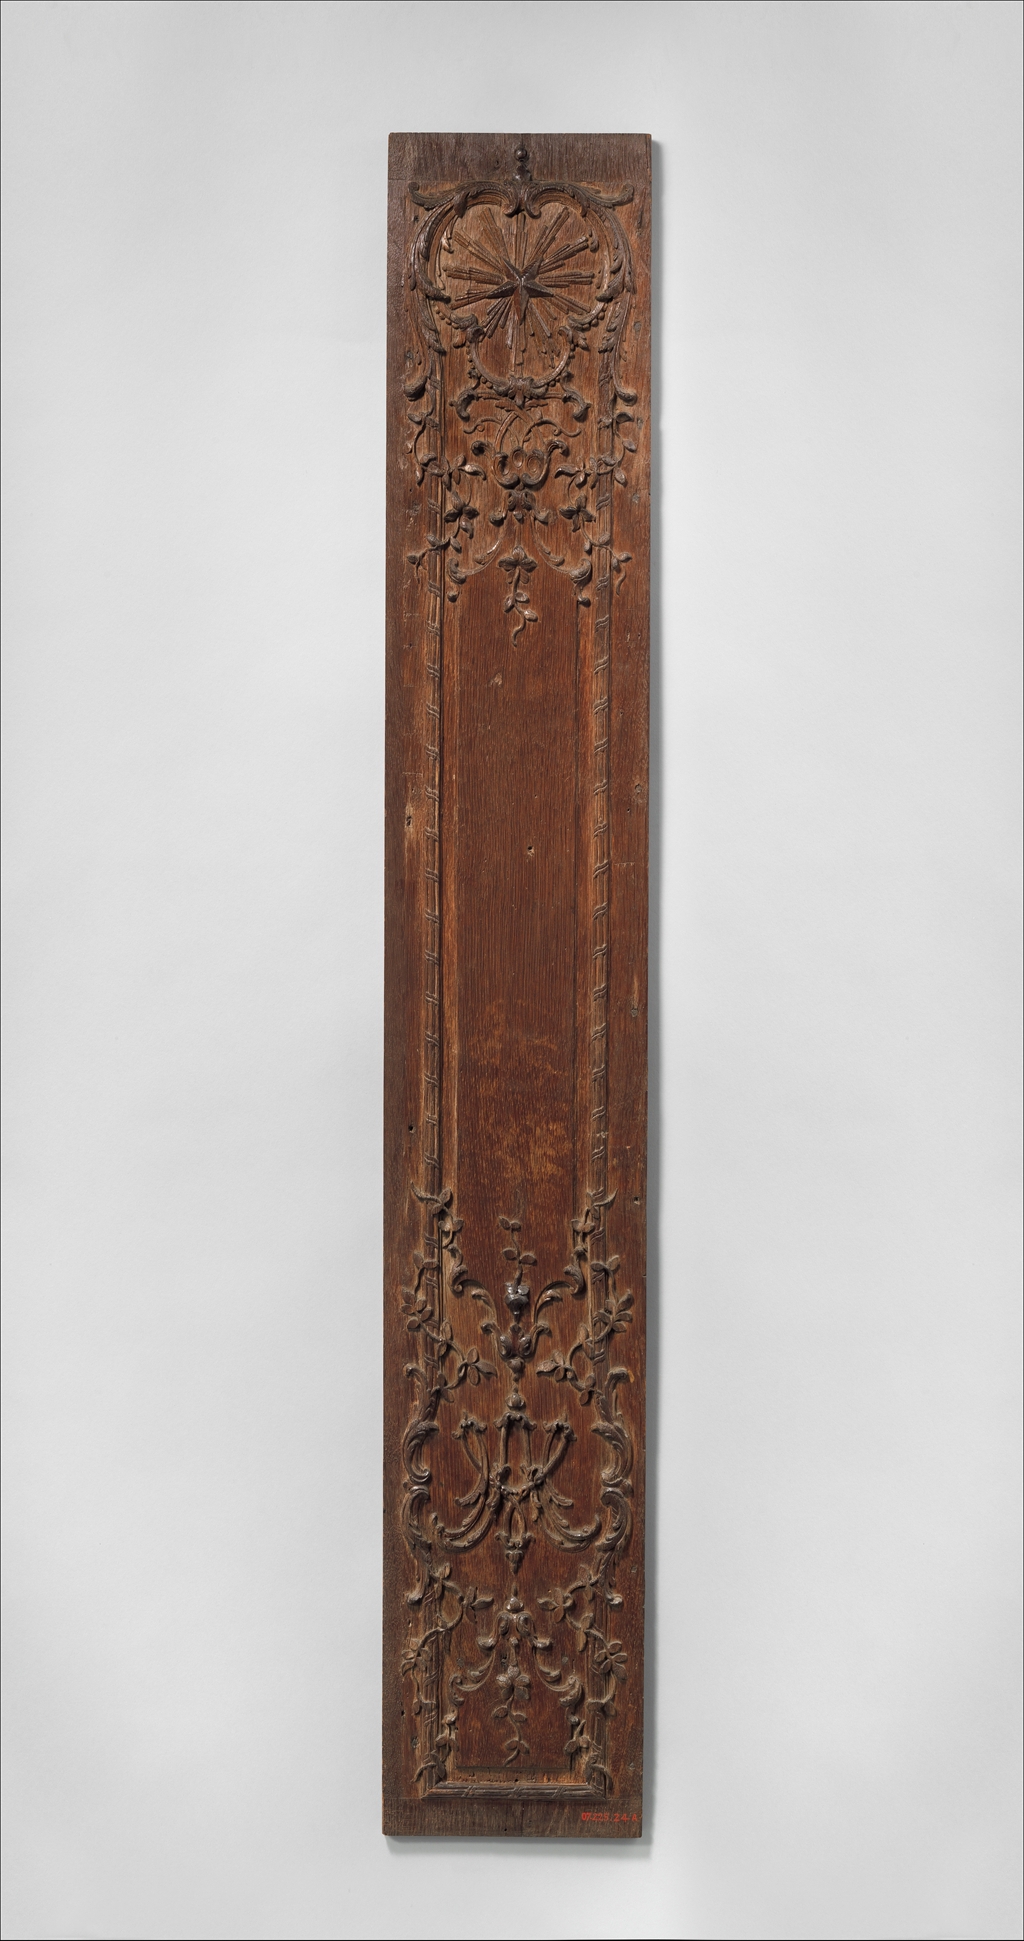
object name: panel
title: Panel (one of a pair)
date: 1730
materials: wood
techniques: carving